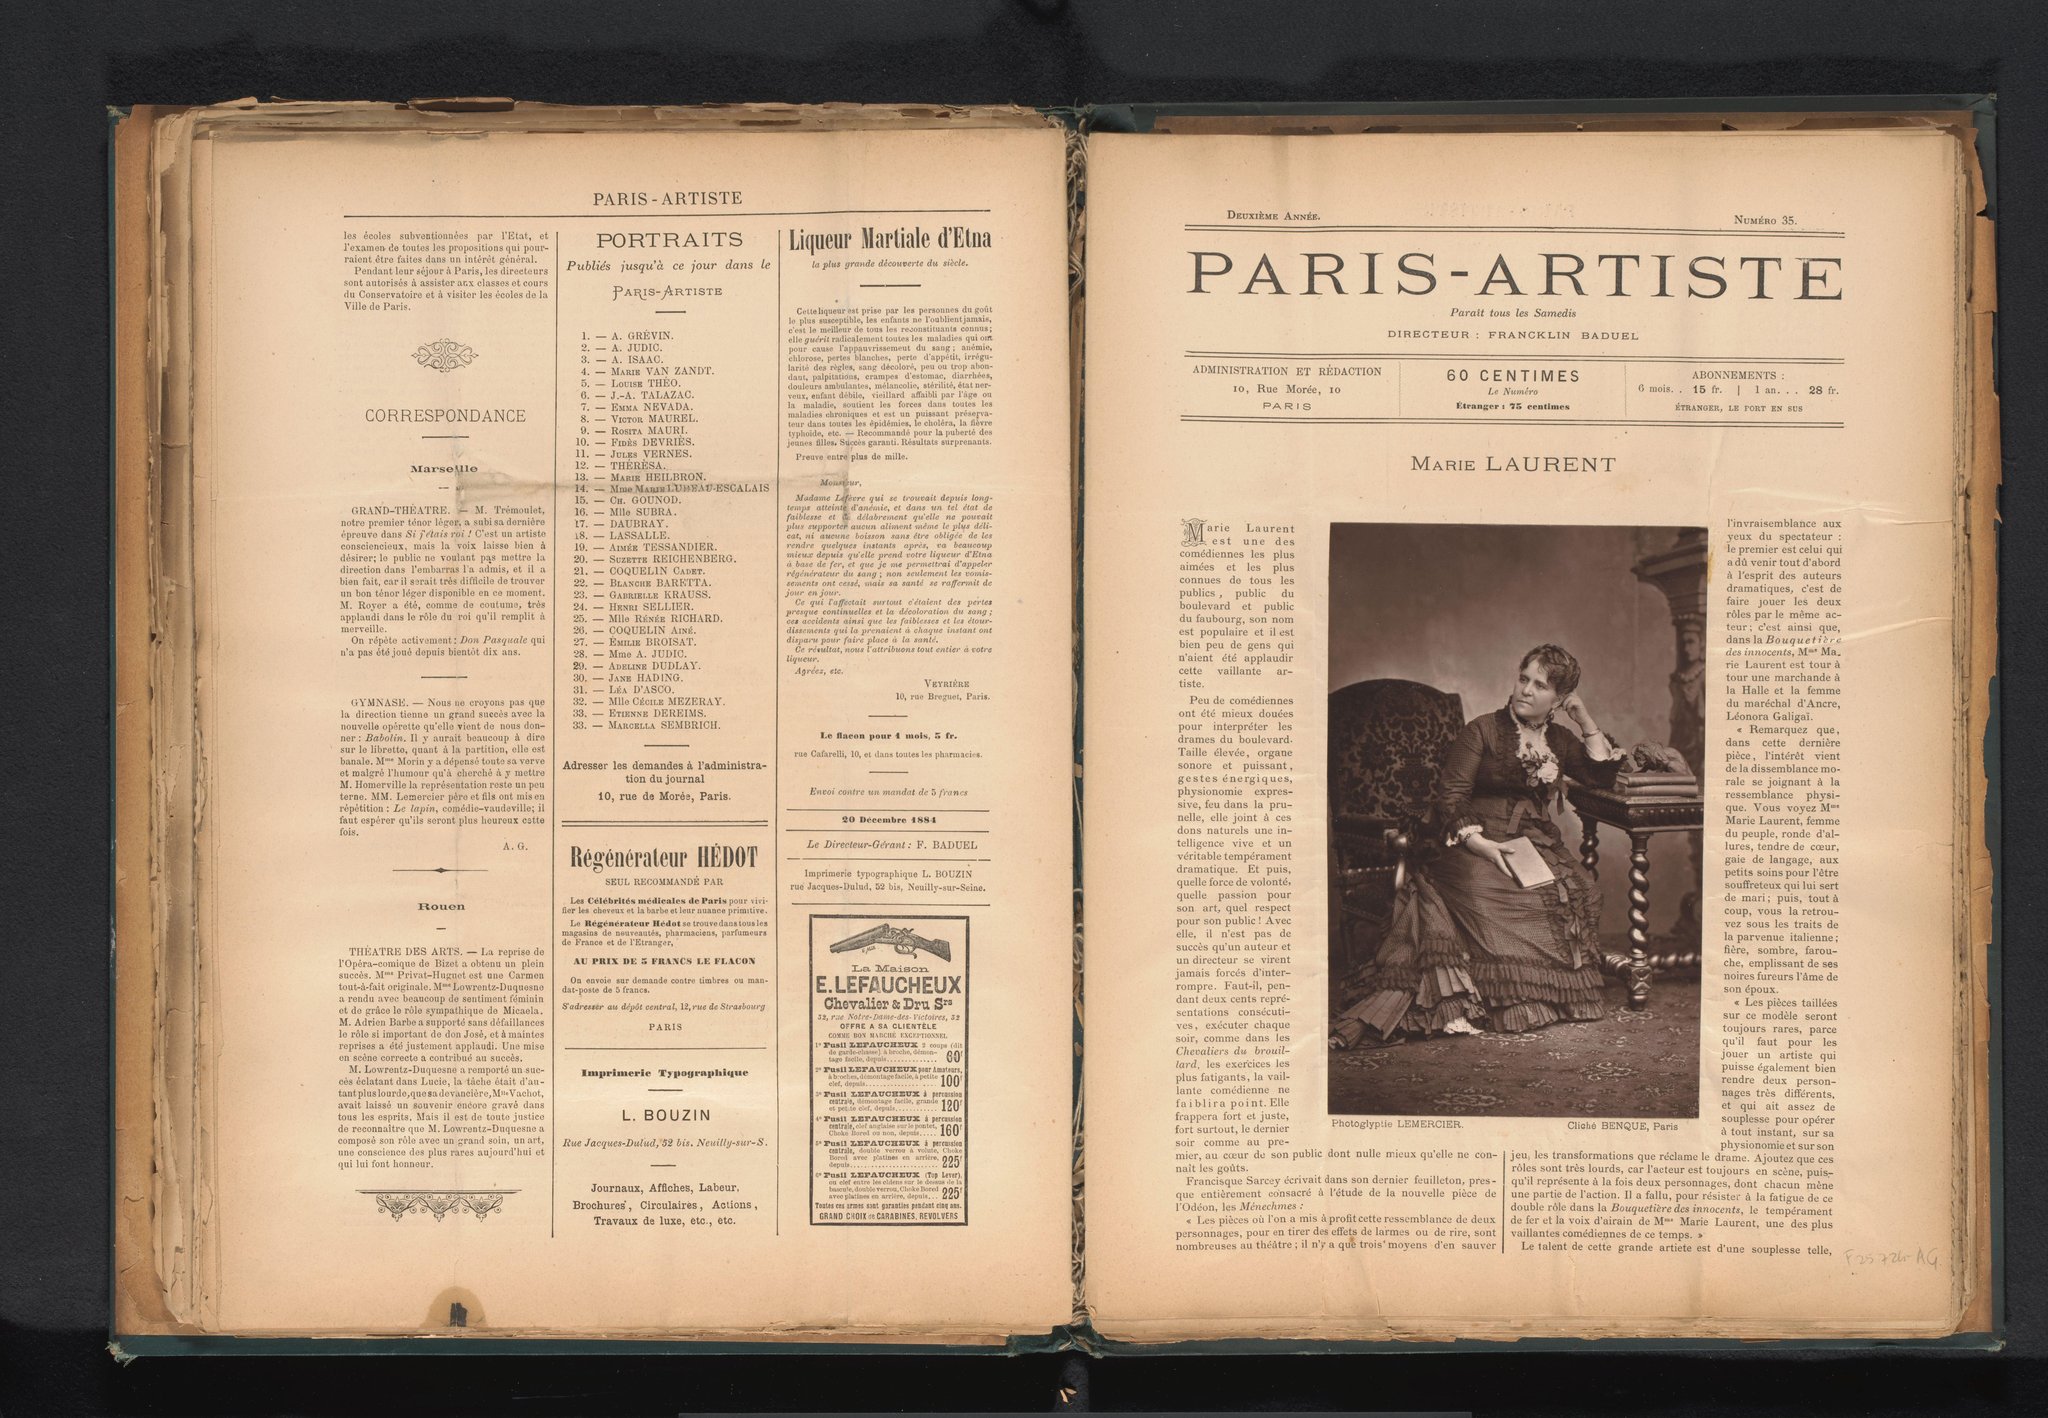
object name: photomechanical print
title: Portret van Marie Laurent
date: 1875-1884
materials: paper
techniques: woodburytype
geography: paris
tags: historical persons - bb - woman, portrait of actor, actress